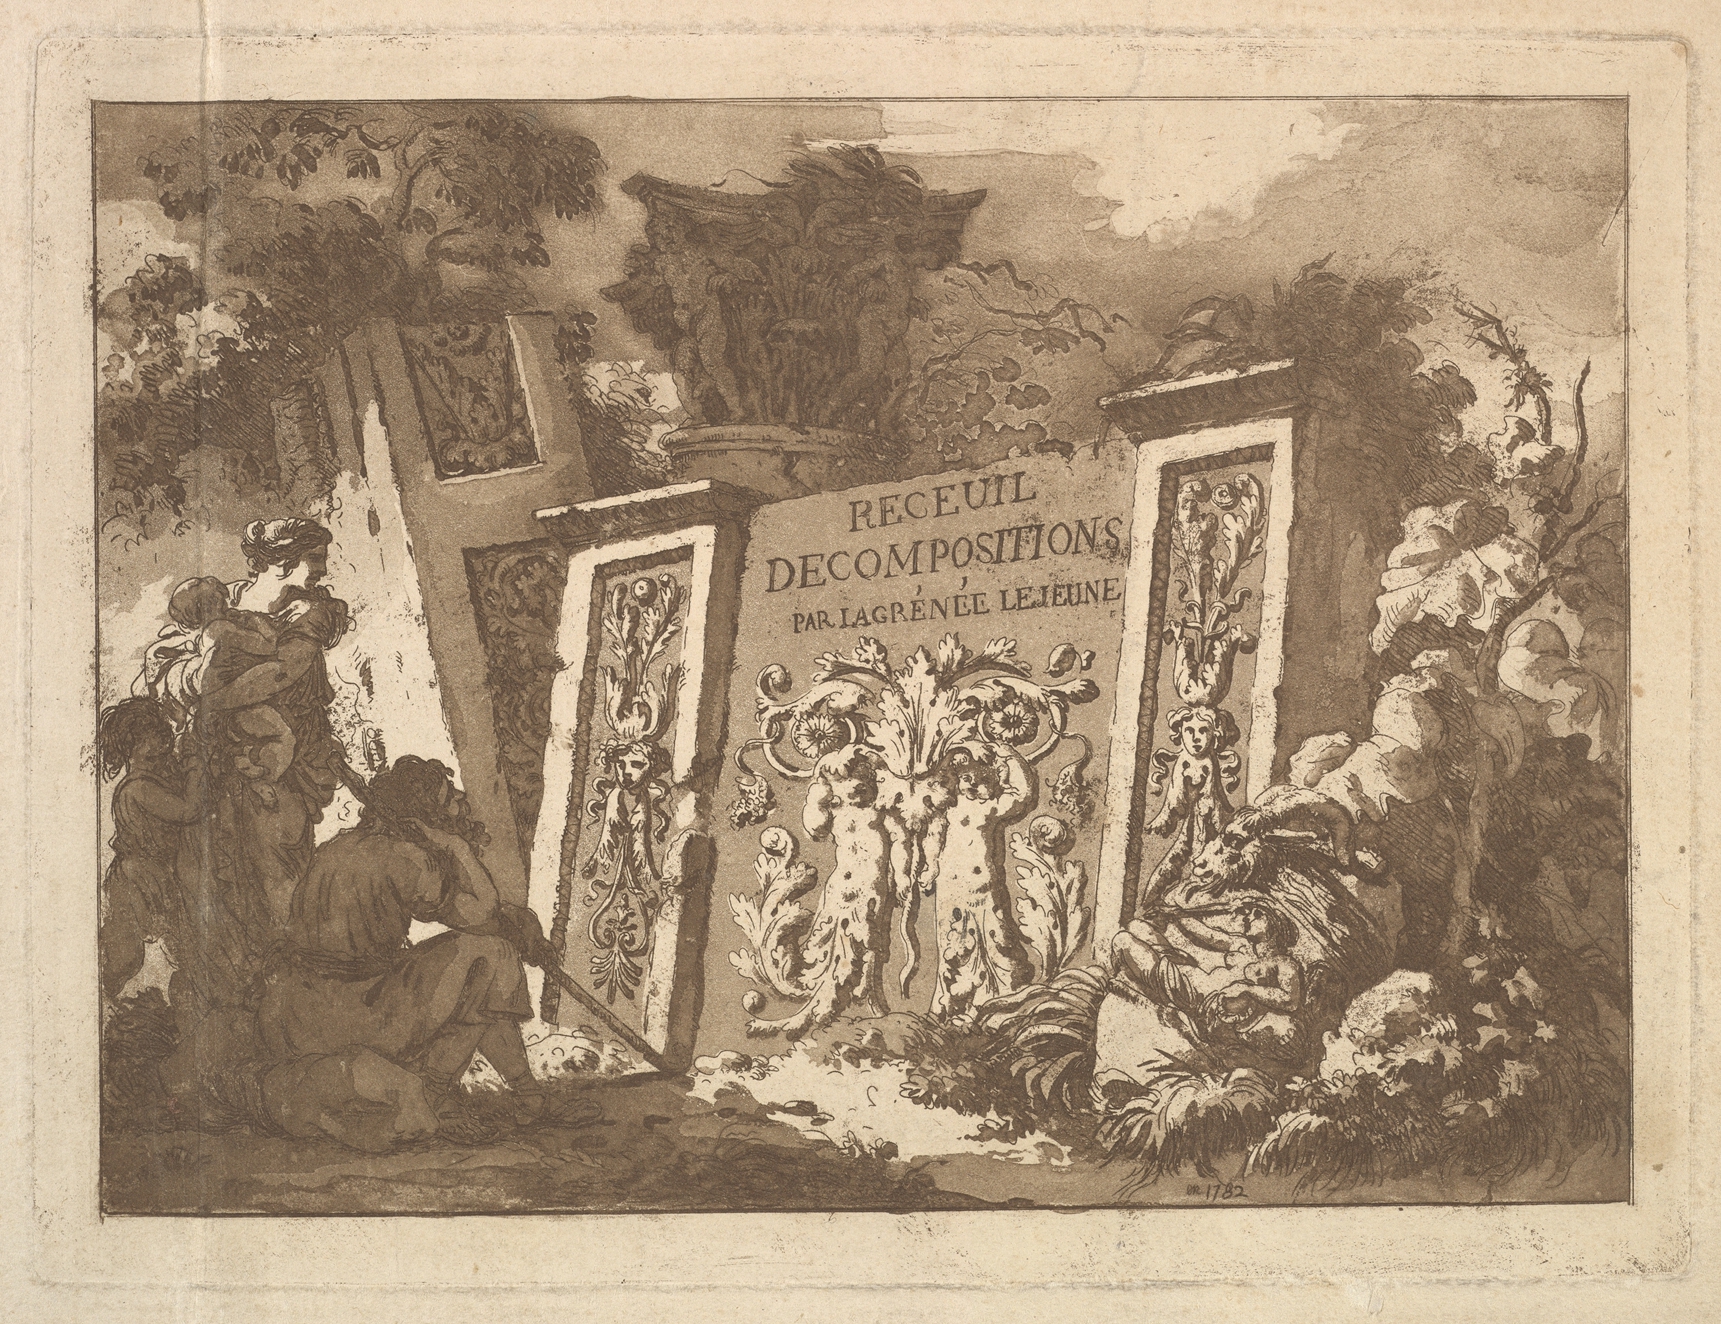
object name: print collection ornament architecture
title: Frontispiece, from "Recueil de Compositions par Lagrenée Le Jeune" (Collection of Compositions by Lagrenée the Younger)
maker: jean jacques lagrenée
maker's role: artist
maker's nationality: french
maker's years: 1739-1821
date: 1782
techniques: aquatint, etching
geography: france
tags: infants,men,women